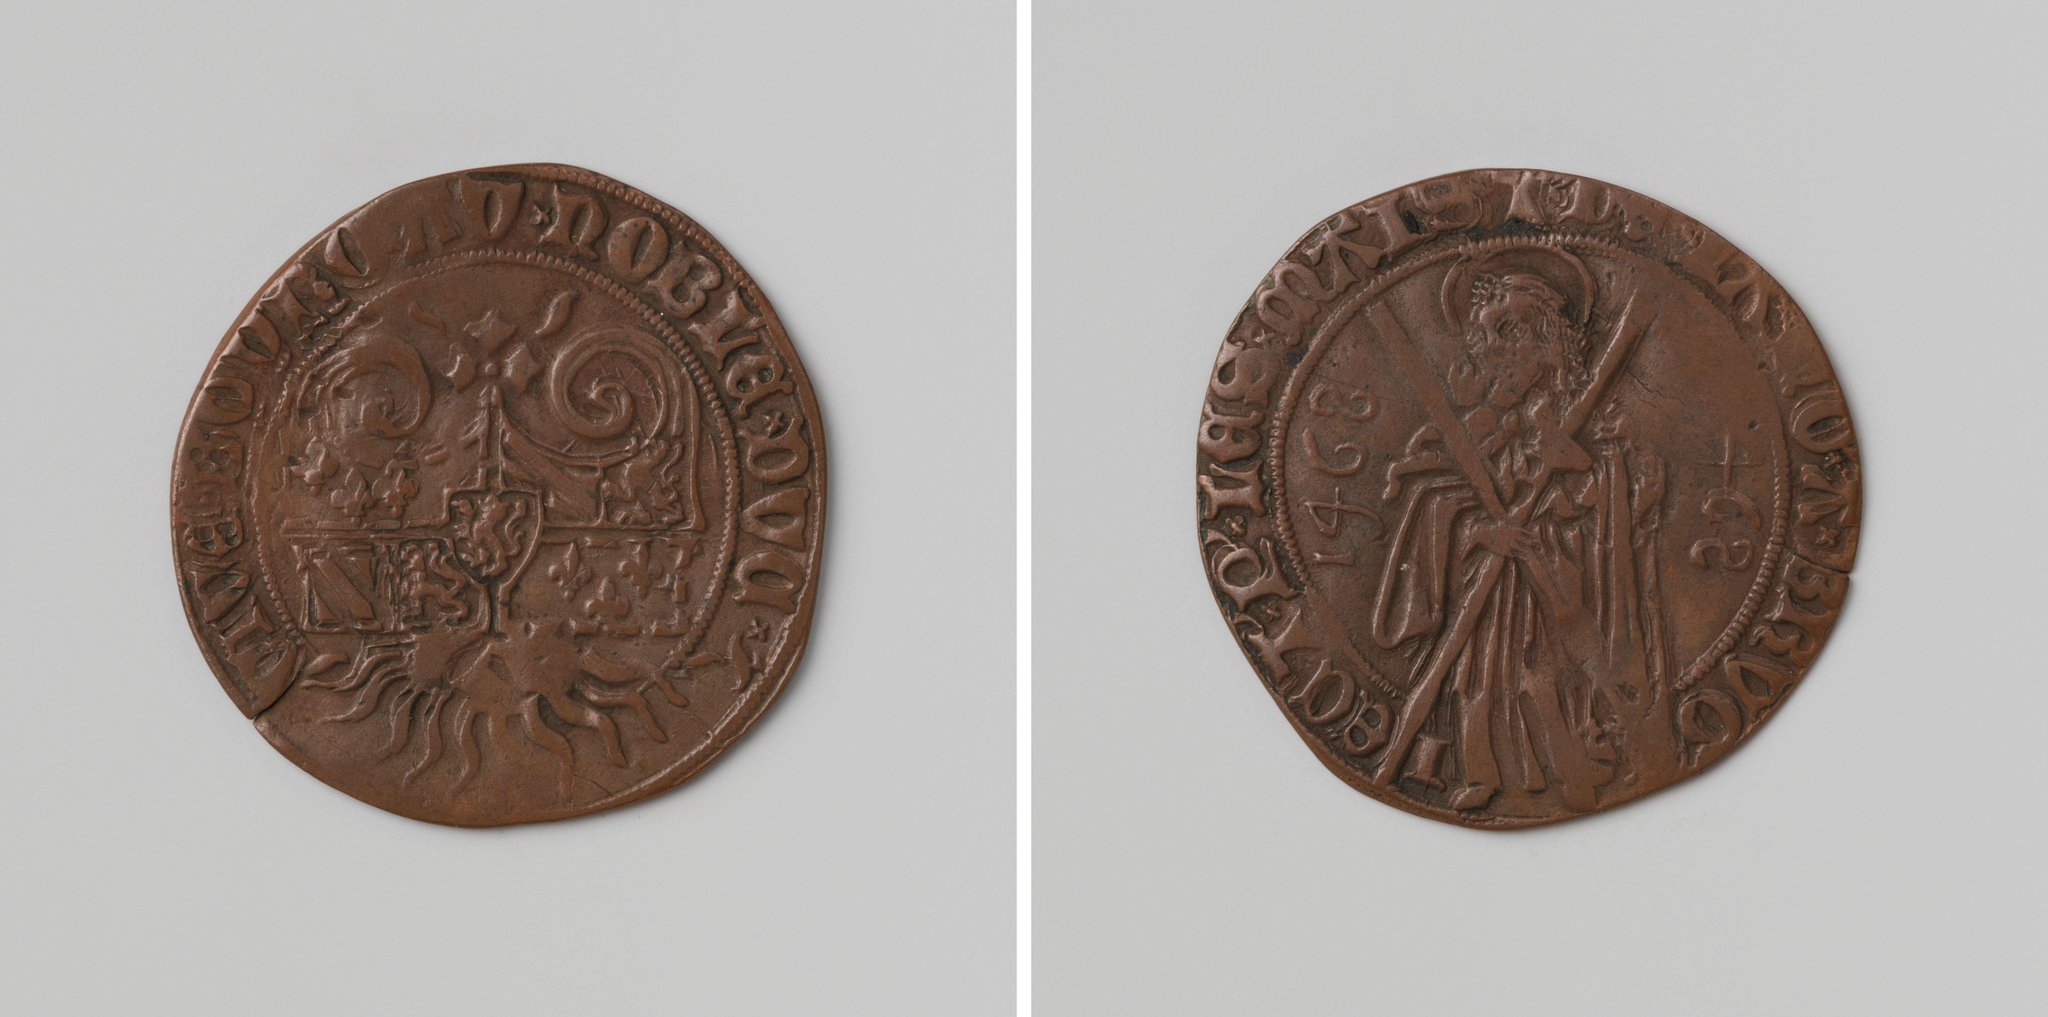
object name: jeton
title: Bijeenkomst van de ridders van het Gulden Vlies te Brugge, rekenpenning van de muntmeester van Brugge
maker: Anonymous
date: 1468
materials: copper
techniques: striking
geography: bruges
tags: bruges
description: Koperen penning. Voorzijde: vuurslag, waar aan onderzijde vonken uitschieten binnen omschrift. Keerzijde: apostel Andries met kruis tussen twee jaartallen binnen omschrift